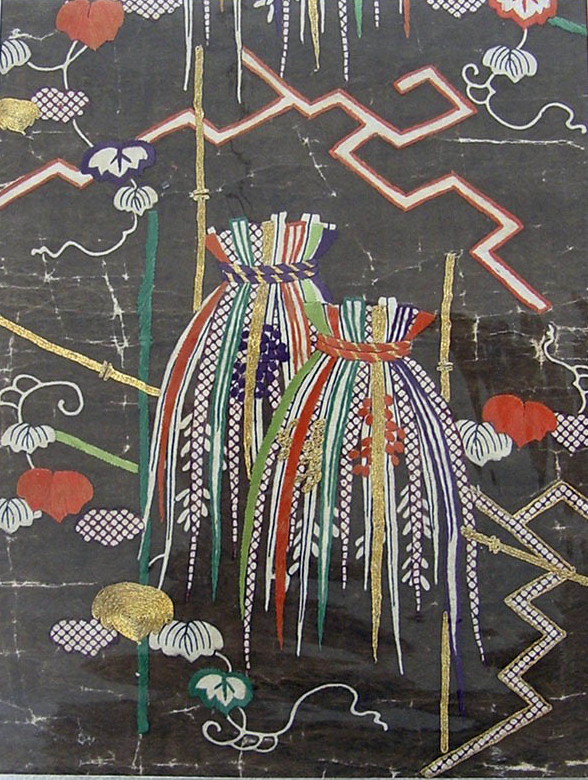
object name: piece from a kosode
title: Piece from a Kosode with Decorated Rice Sheaves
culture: japanese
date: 1615-1868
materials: metal thread, silk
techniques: damask, dyeing, embroidery, painting, resist